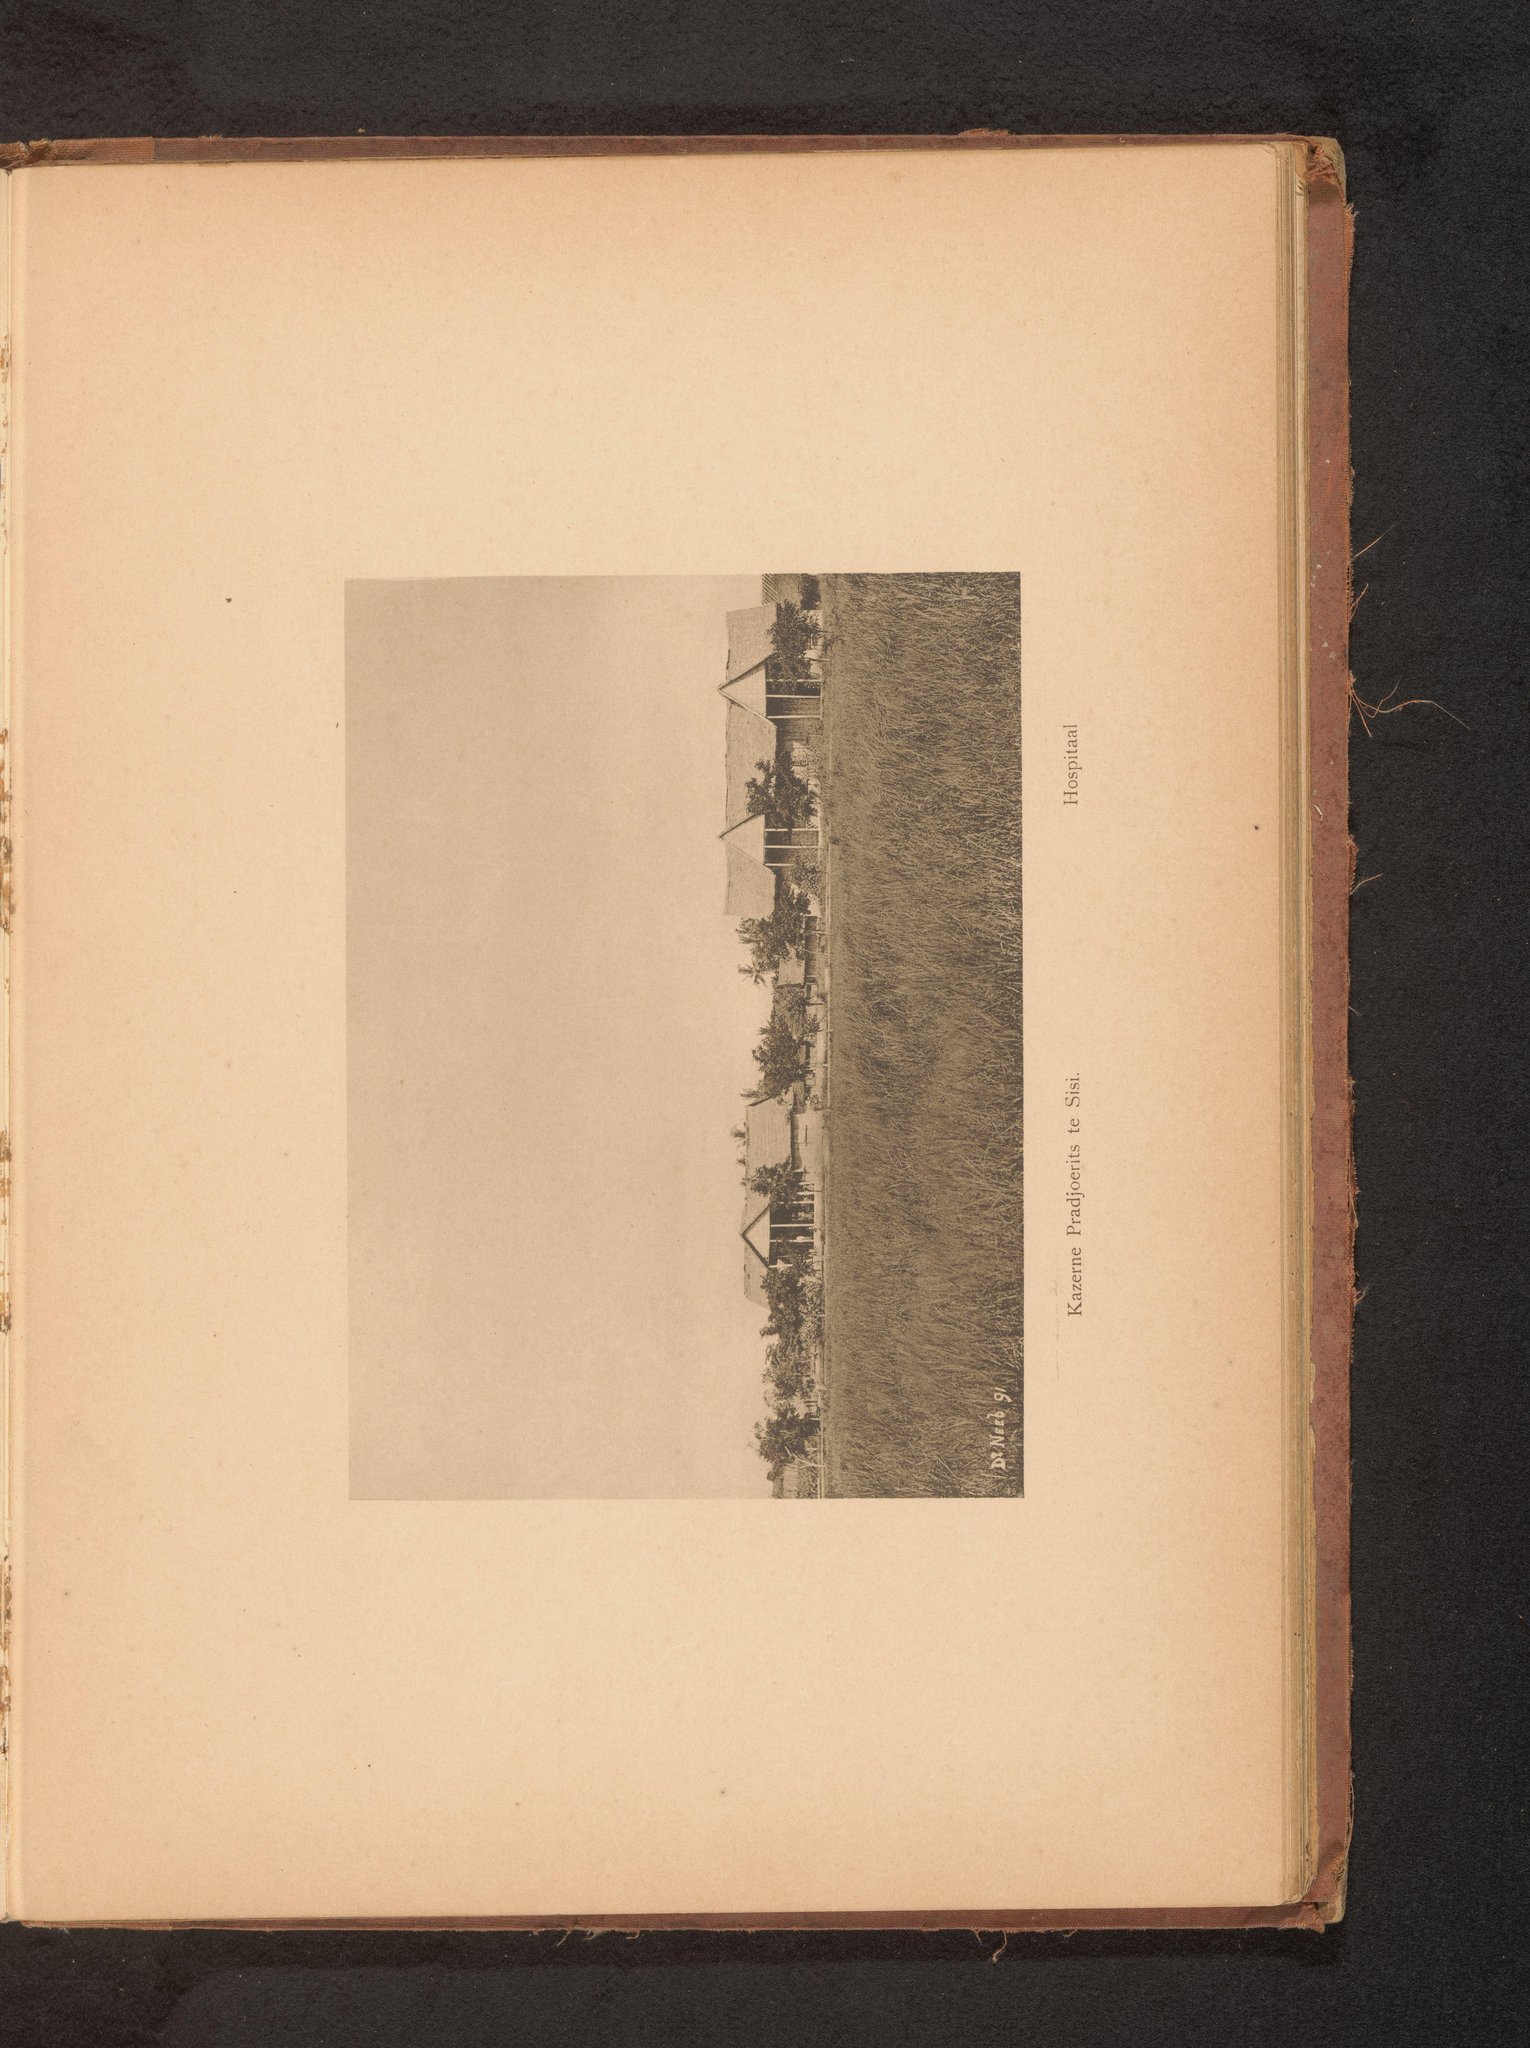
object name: photomechanical print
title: Gezicht op een kazerne te Sisi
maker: christiaan johan neeb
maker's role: arts, fotograaf, officier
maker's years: 1860-1925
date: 1892-1897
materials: paper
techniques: photograph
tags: barracks